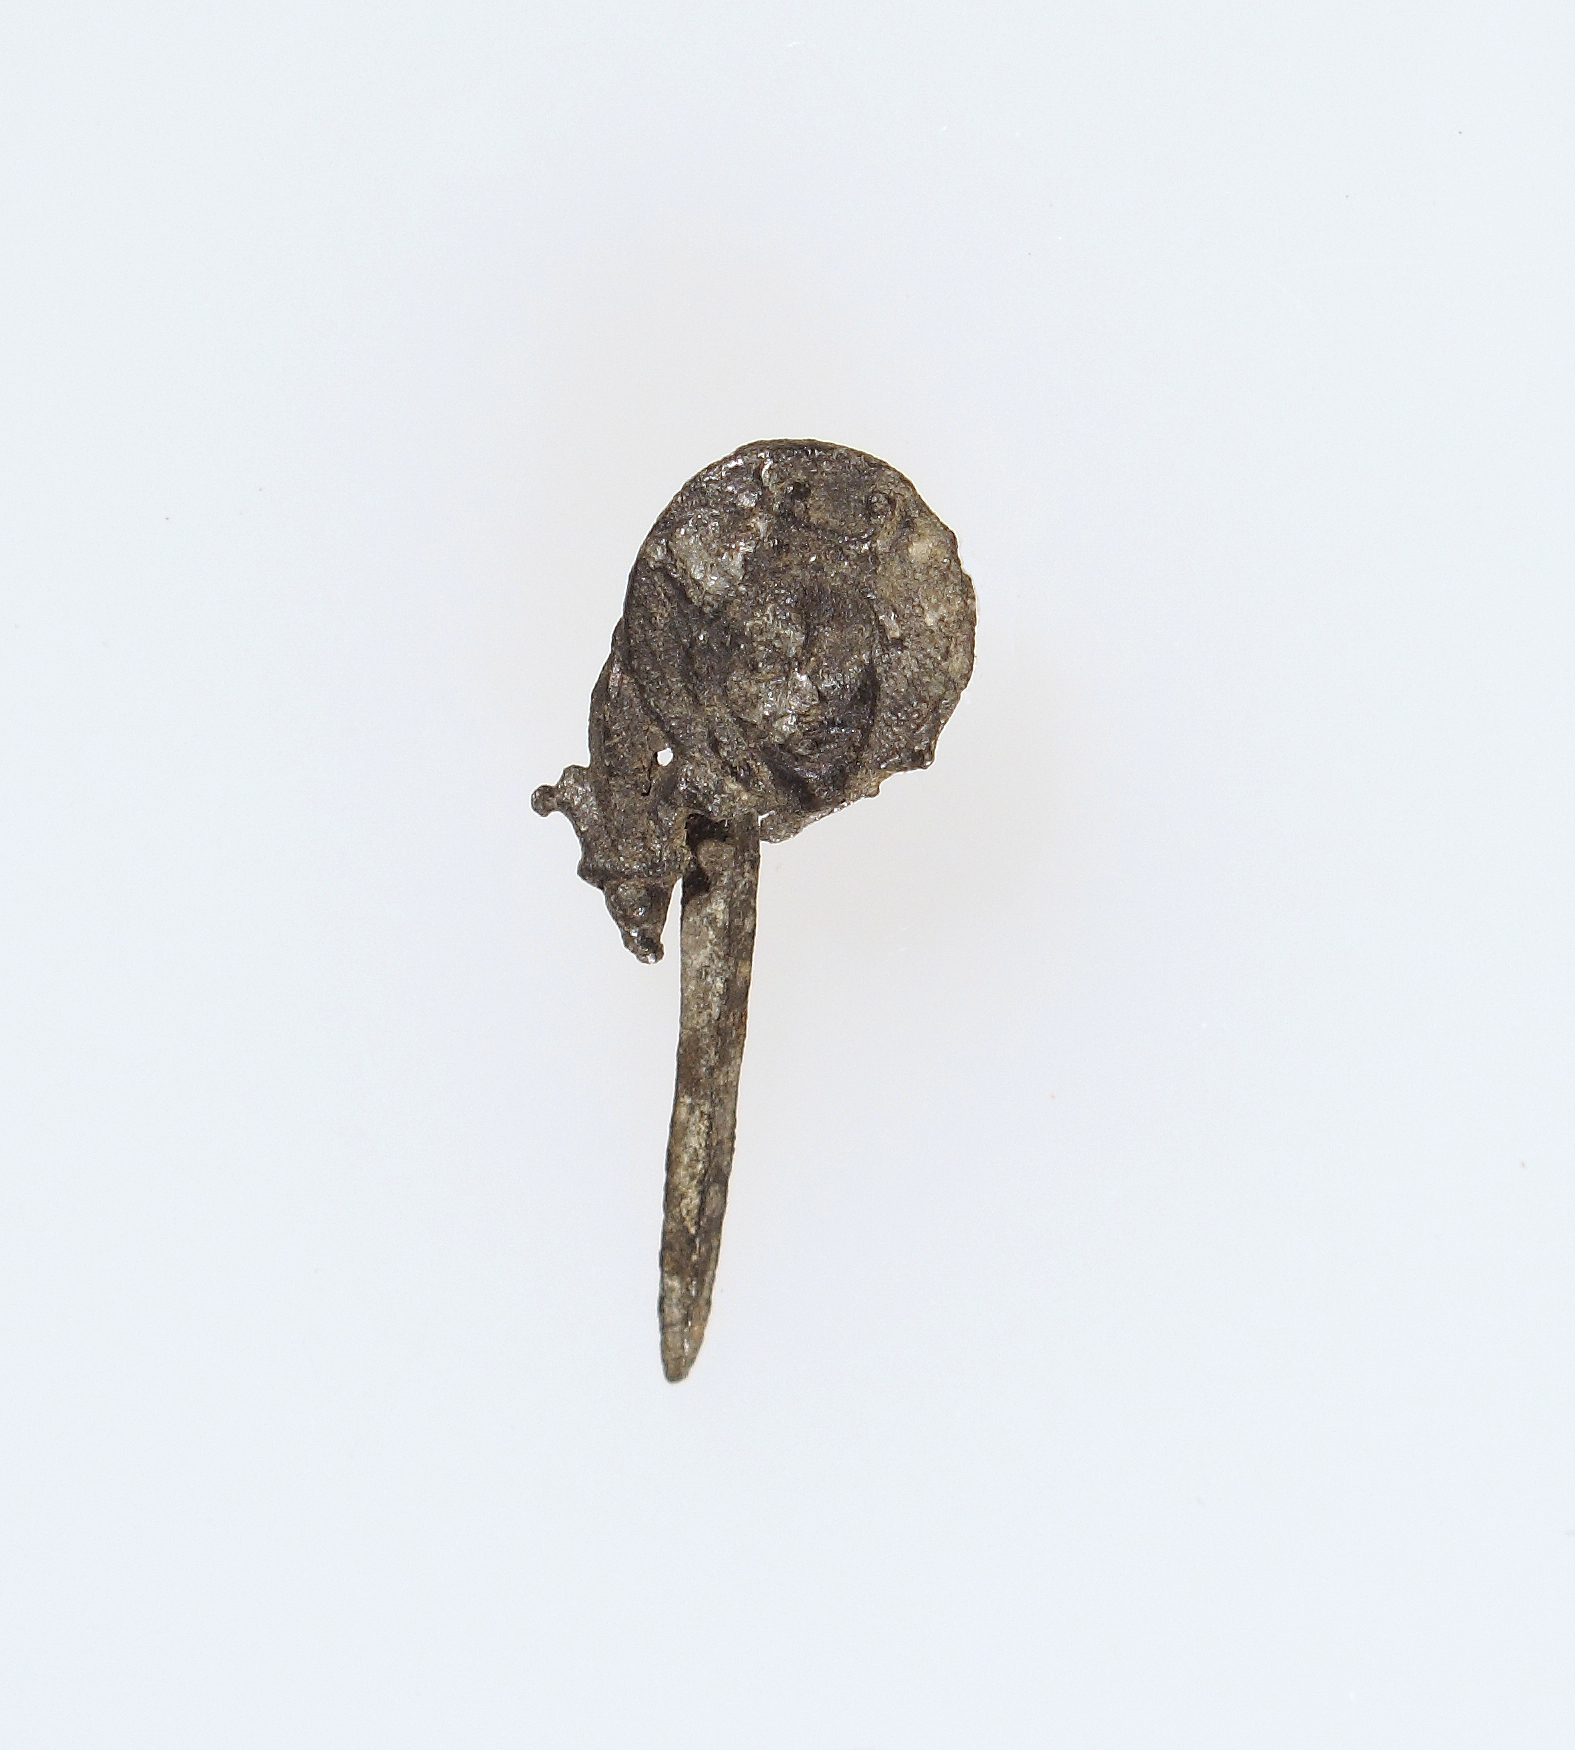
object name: pilgrim's badge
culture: french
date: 1301-1600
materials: lead